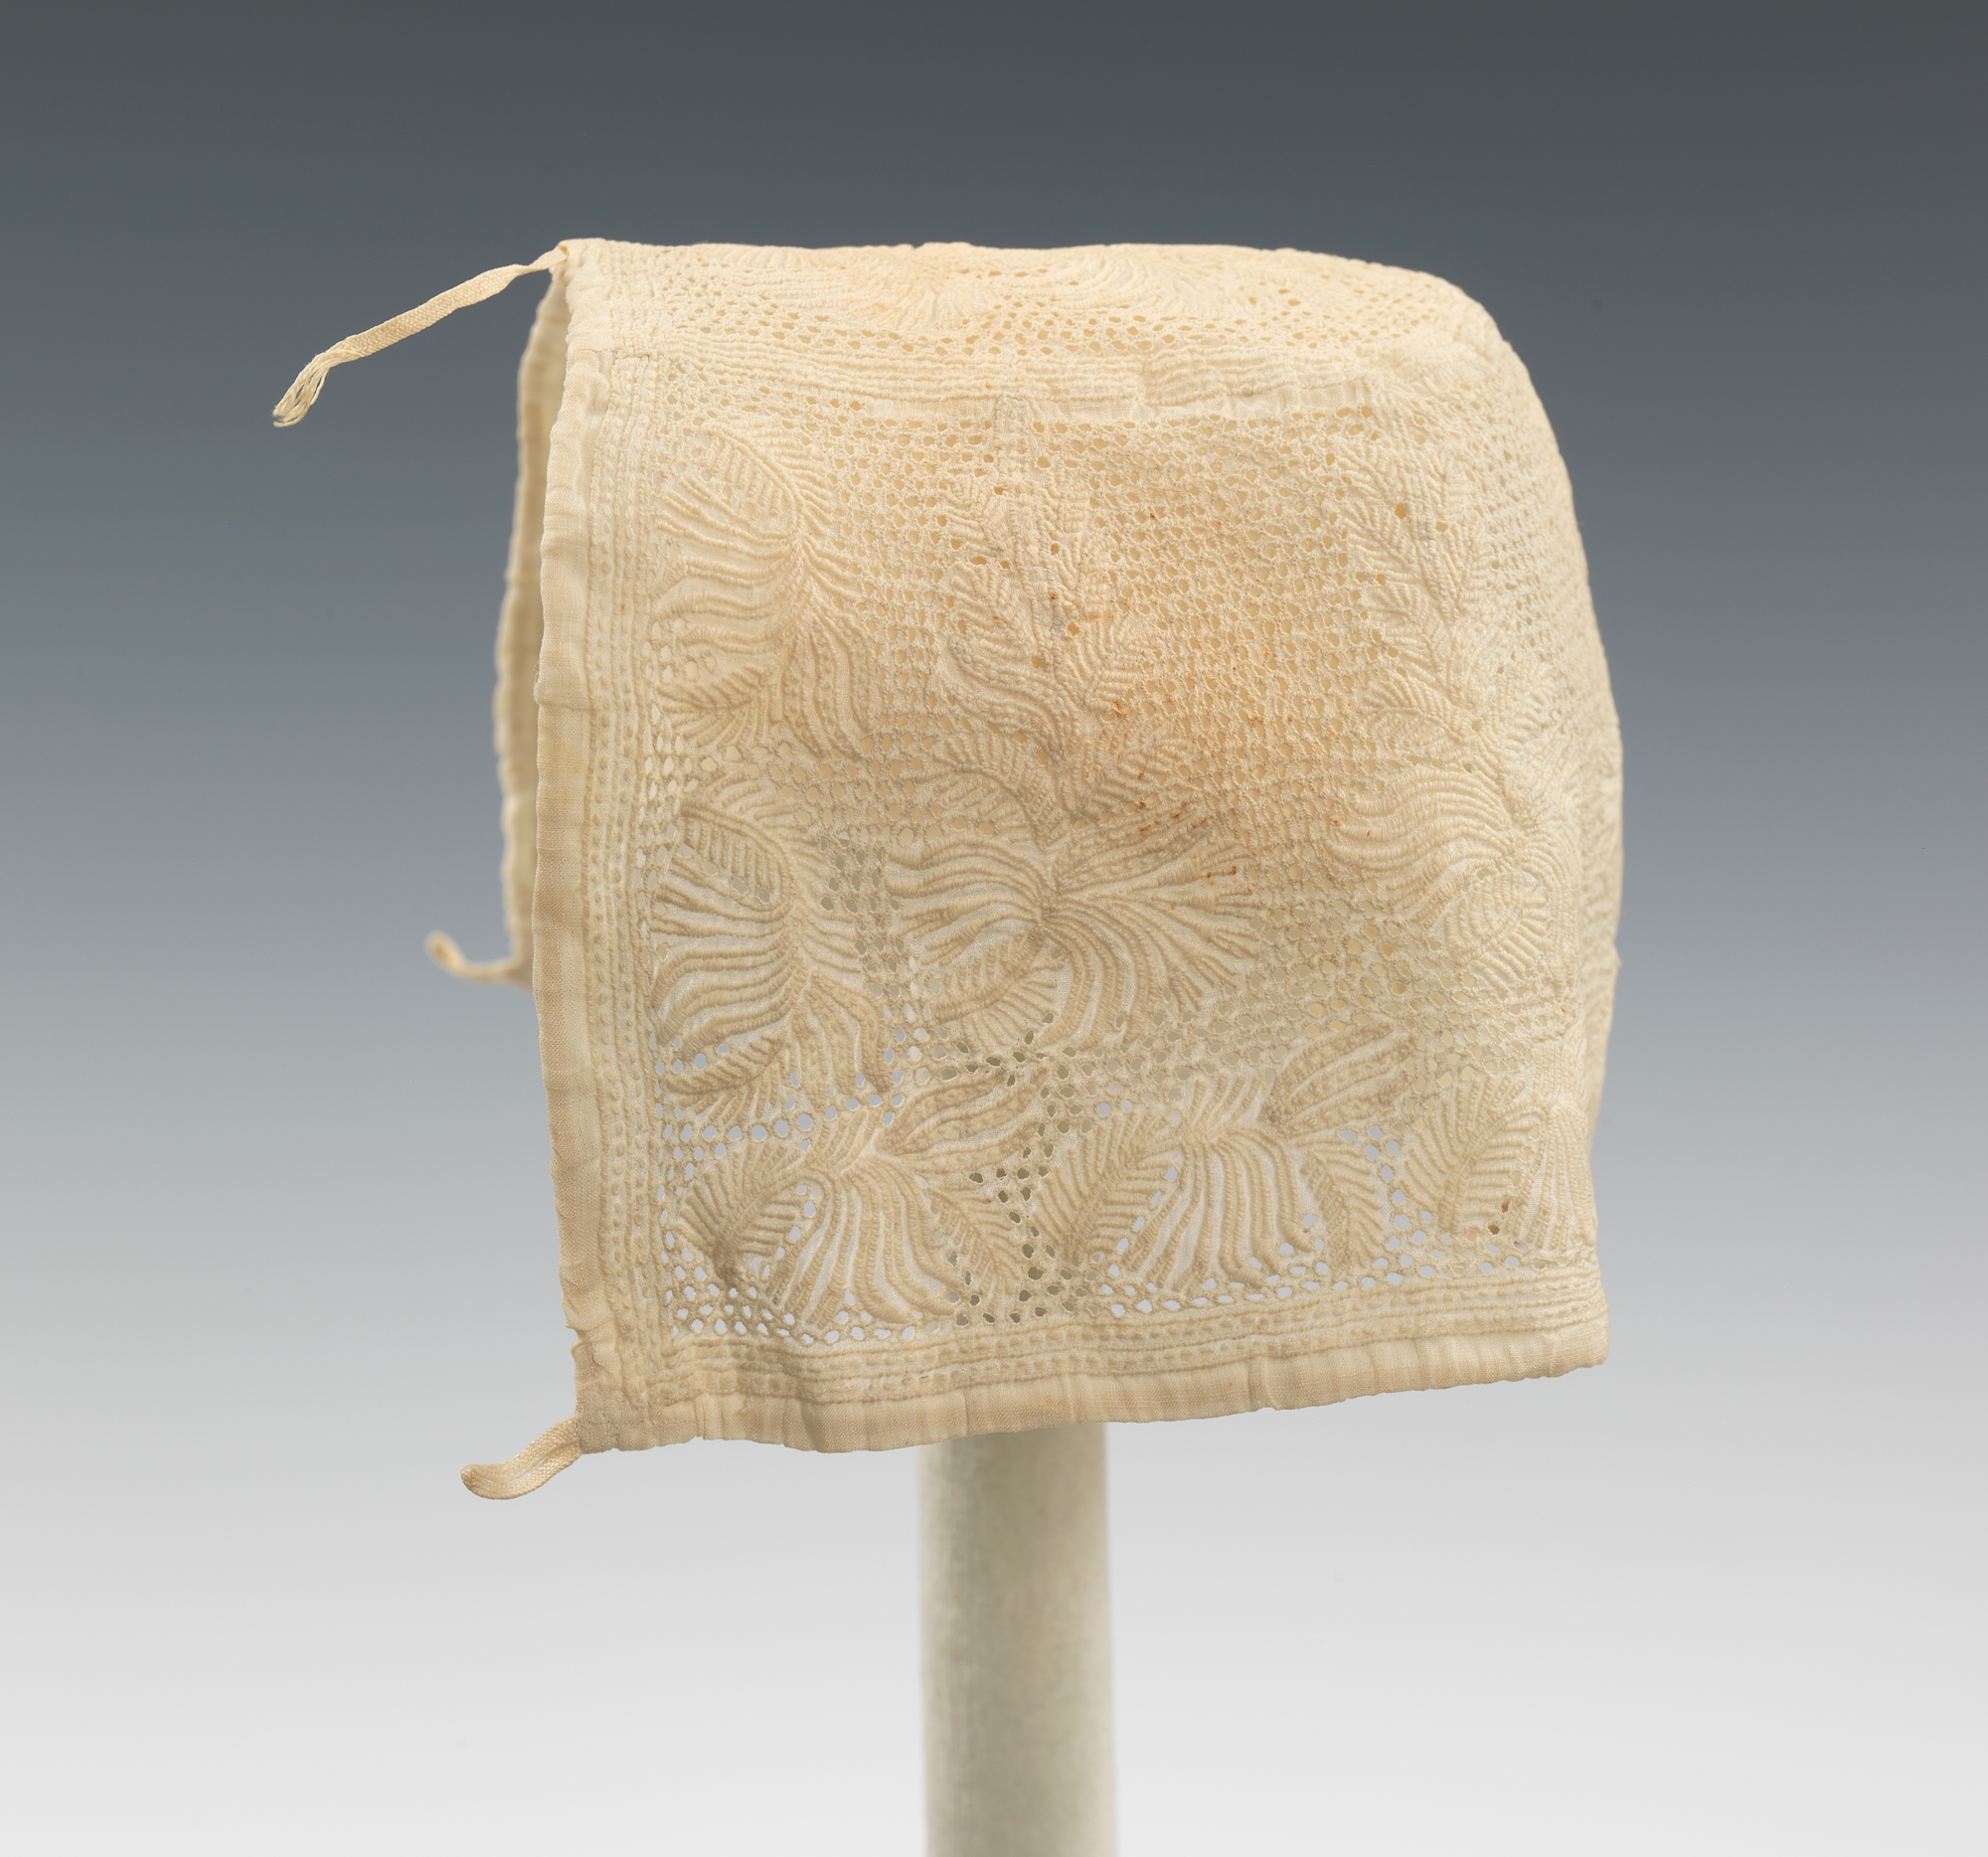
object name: cap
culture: american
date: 1820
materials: cotton